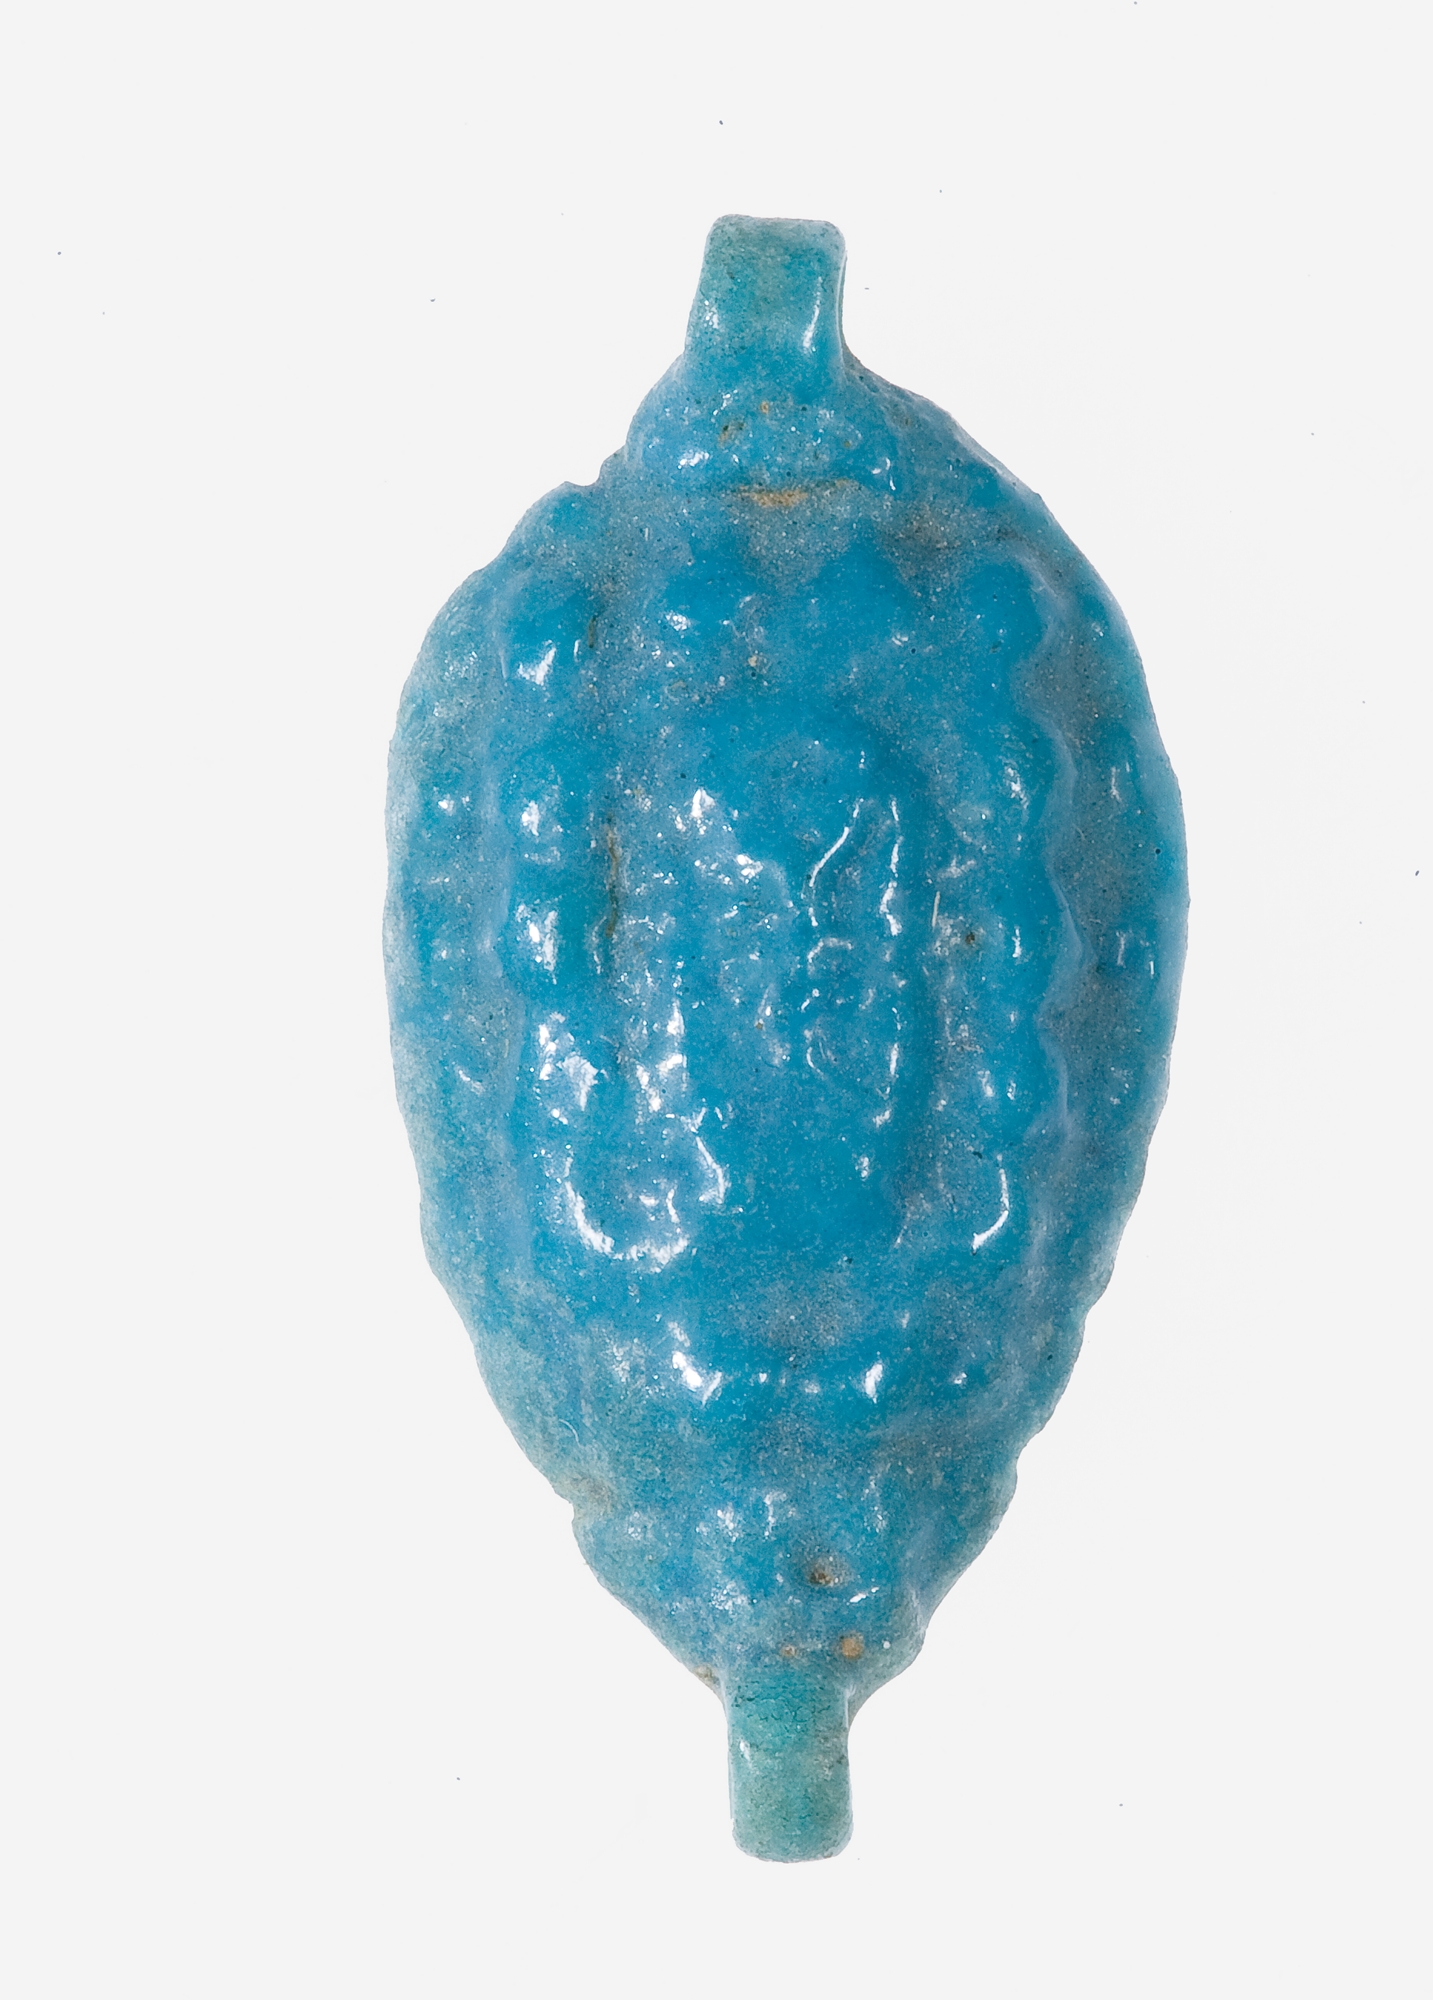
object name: pendant, grape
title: Pendant: Bunch of Grapes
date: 1390-1352 BCE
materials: faience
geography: egypt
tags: grapes